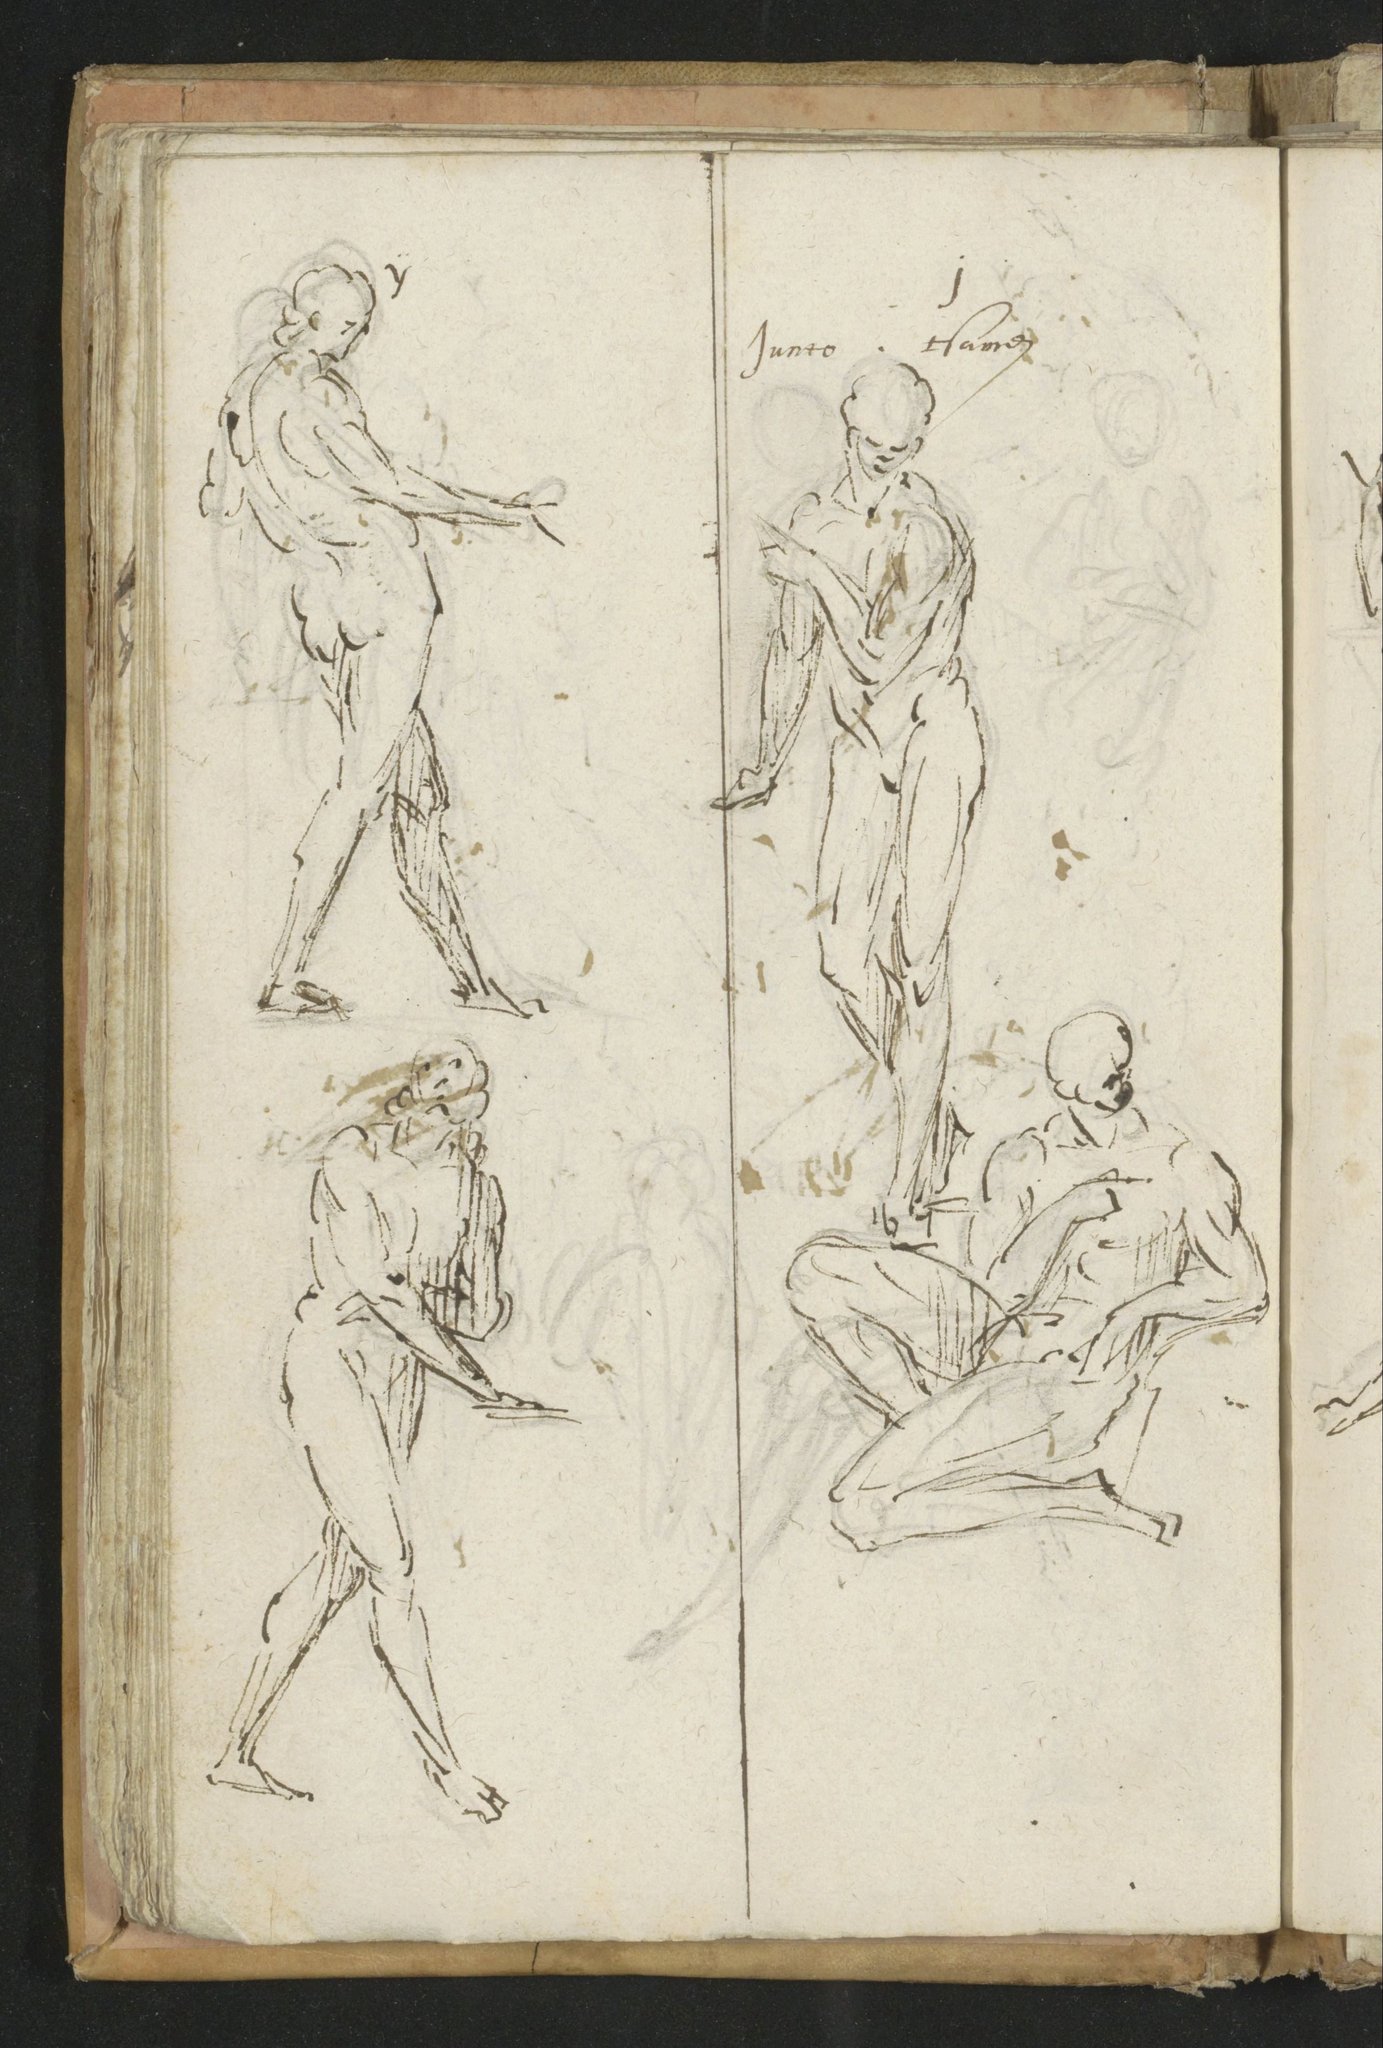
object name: sketchbook leaf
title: Vier naakte mannen die verschillende handbewegingen maken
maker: Anonymous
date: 1658-1728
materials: ink, paper, pencil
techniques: pen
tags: postures and gestures of the hand, the (nude) human figure; 'corpo humano' (ripa)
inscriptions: annotation: ‘y/ j/ Junto . Hand’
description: Blad 21 verso uit een schetsboek met 33 bladen.